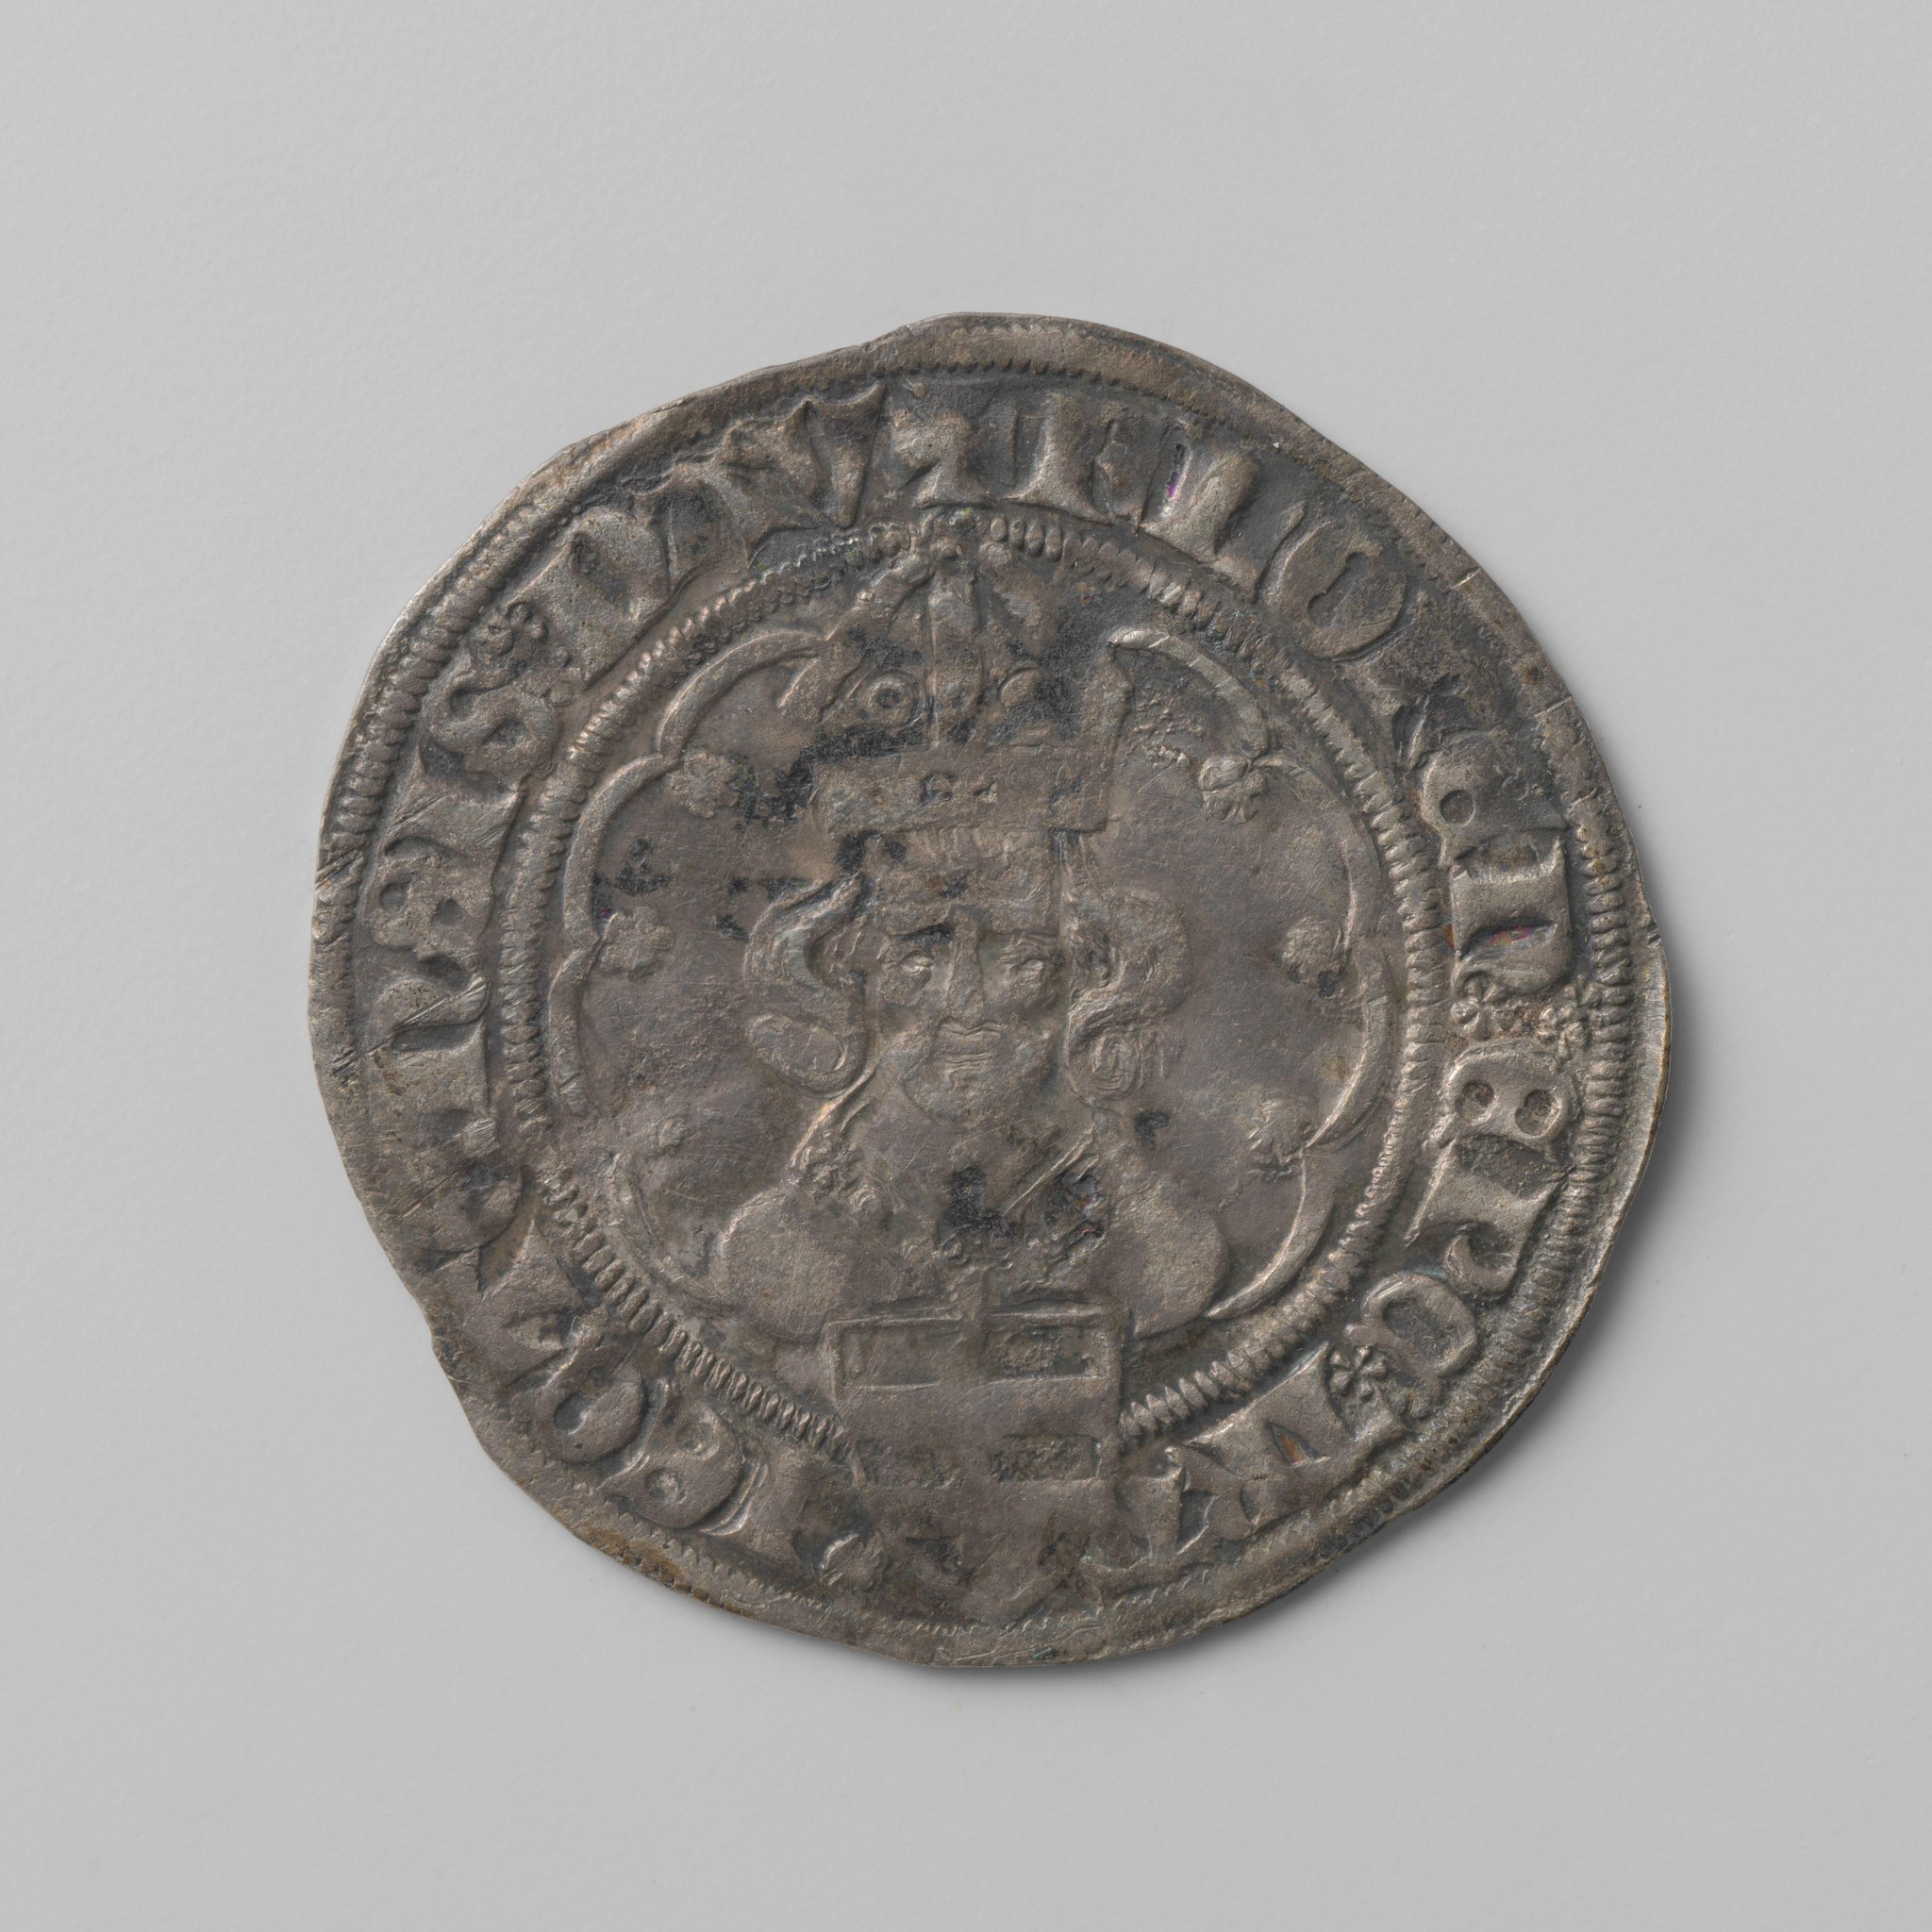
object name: coin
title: Utrechtse dubbele groot van Floris van Wevelinghoven, 1379-1393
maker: floris van wevelinkhoven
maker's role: bisschop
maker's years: 1315-1393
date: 1379-1393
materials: silver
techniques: striking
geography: deventer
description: Zilveren munt. Voorzijde: binnen versierde veelpas aanziend portret van de bisschop met mijter met voor zich wapenschild van Wevelinghoven. Keerzijde: adelaar met onder zijn poten wapenschild van Utrecht.